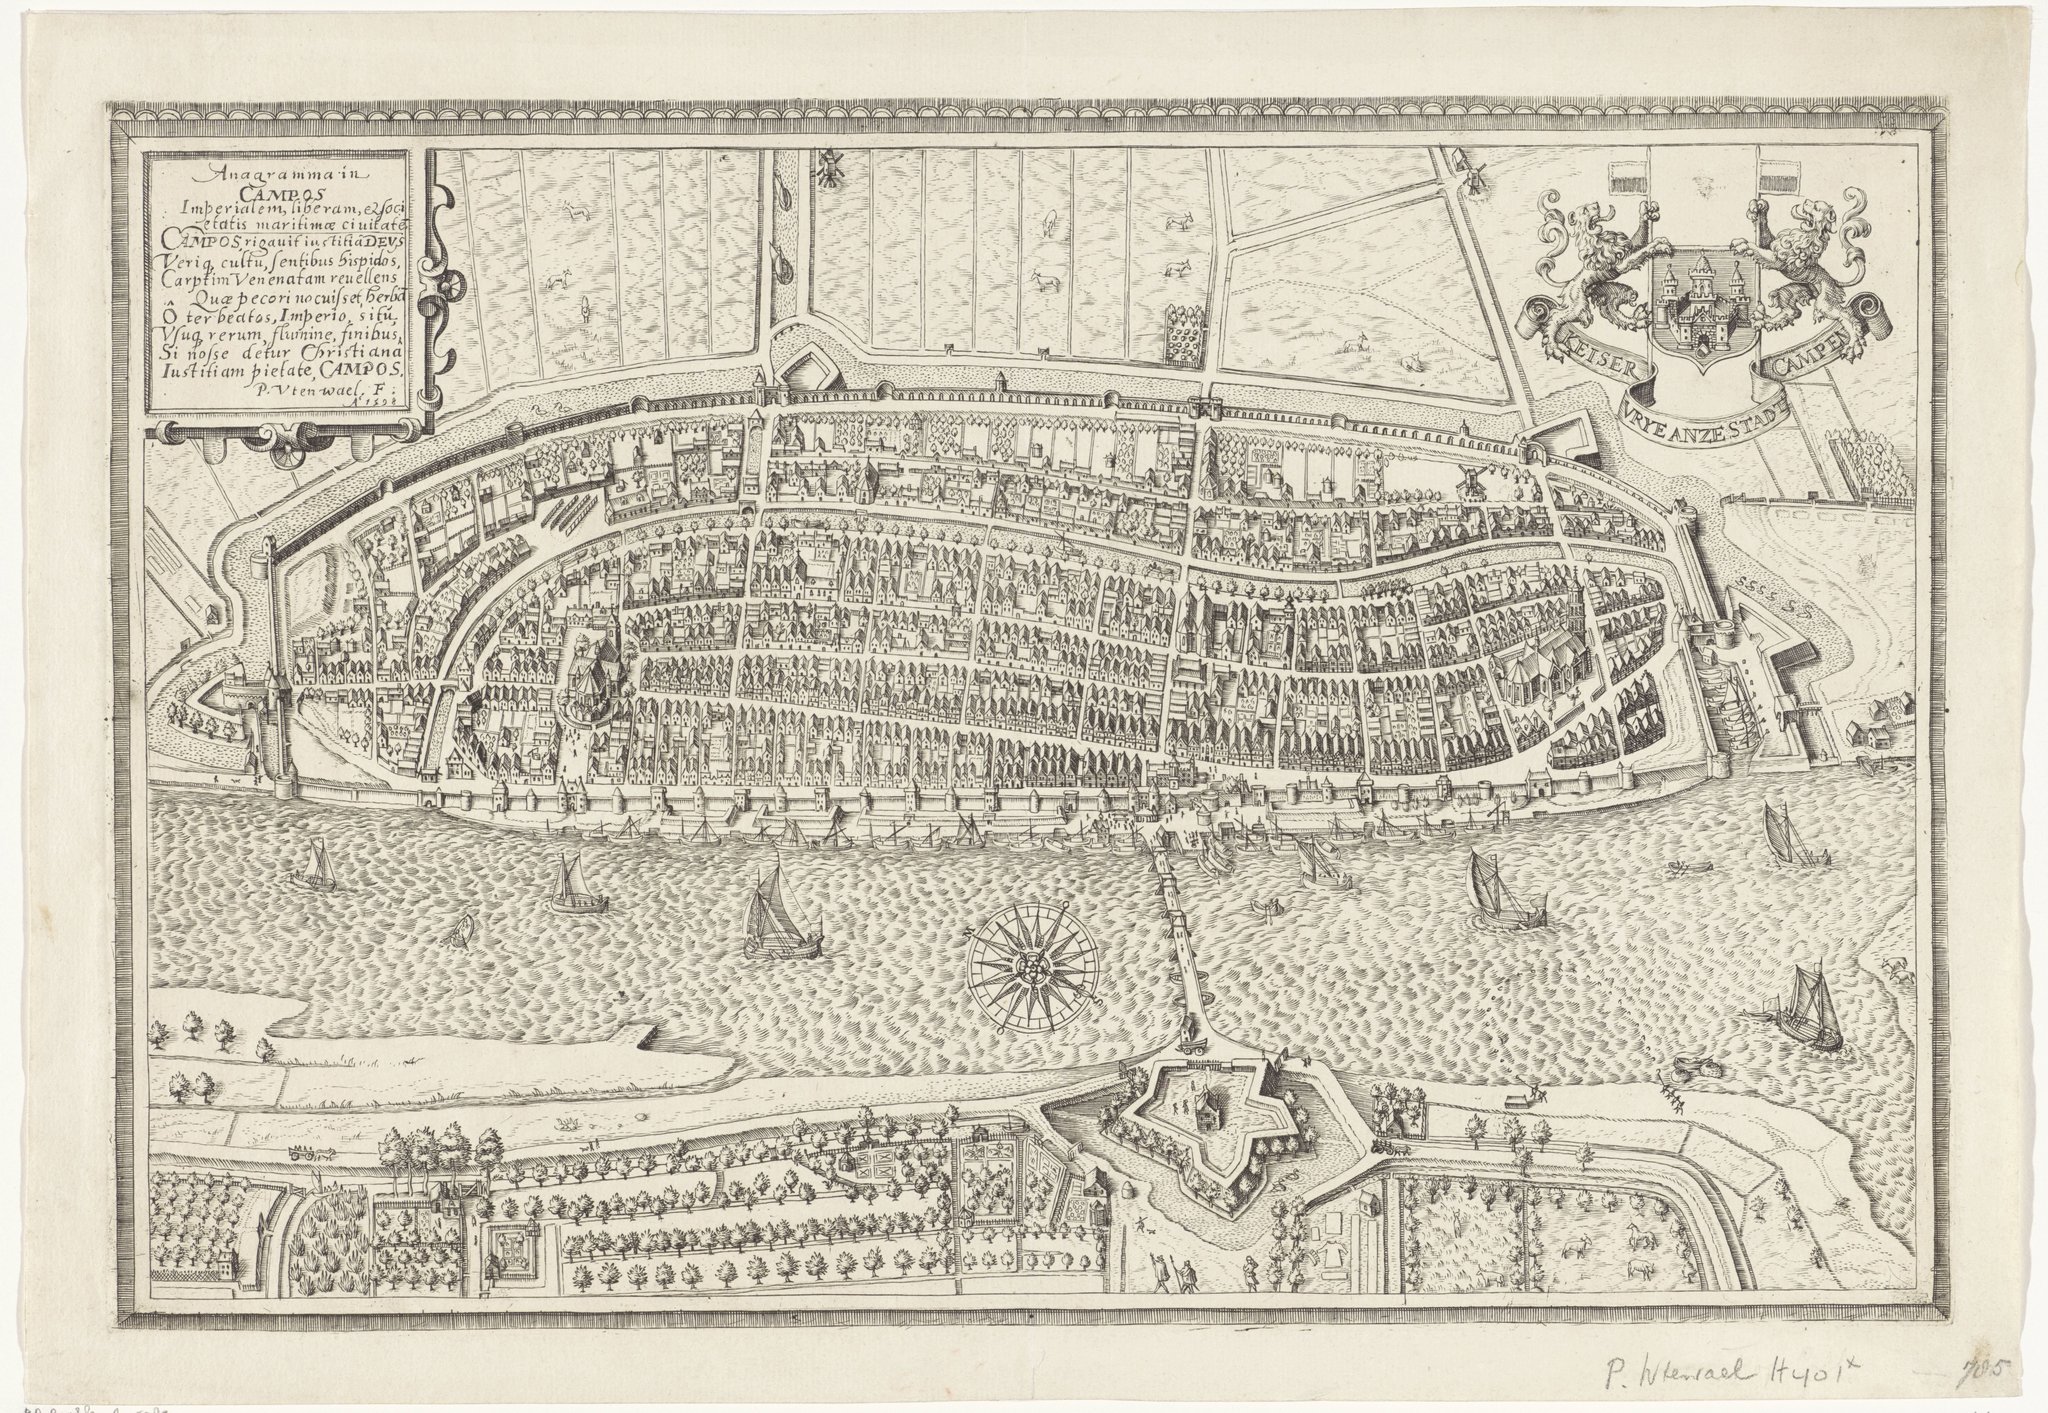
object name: print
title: Plattegrond van Kampen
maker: paulus van wtewael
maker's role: die cutter, draughtsman, print maker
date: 1598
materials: paper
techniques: engraving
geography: northern netherlands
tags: maps, atlases, armorial bearing, heraldry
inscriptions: collector's mark: Lugt 2228, signature and date: ‘P. Vtenwael F. 1598’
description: Plattegrond van de stad Kampen, gezien vanuit vogelperspectief. Op de rivier langs de stad diverse schepen. Op de voorgrond de vesting en tuinen. Midden onder een kompas. Linksboven in een kader een twaalfregelig opschrift in het Latijn. Rechtsboven het wapen van Kampen.